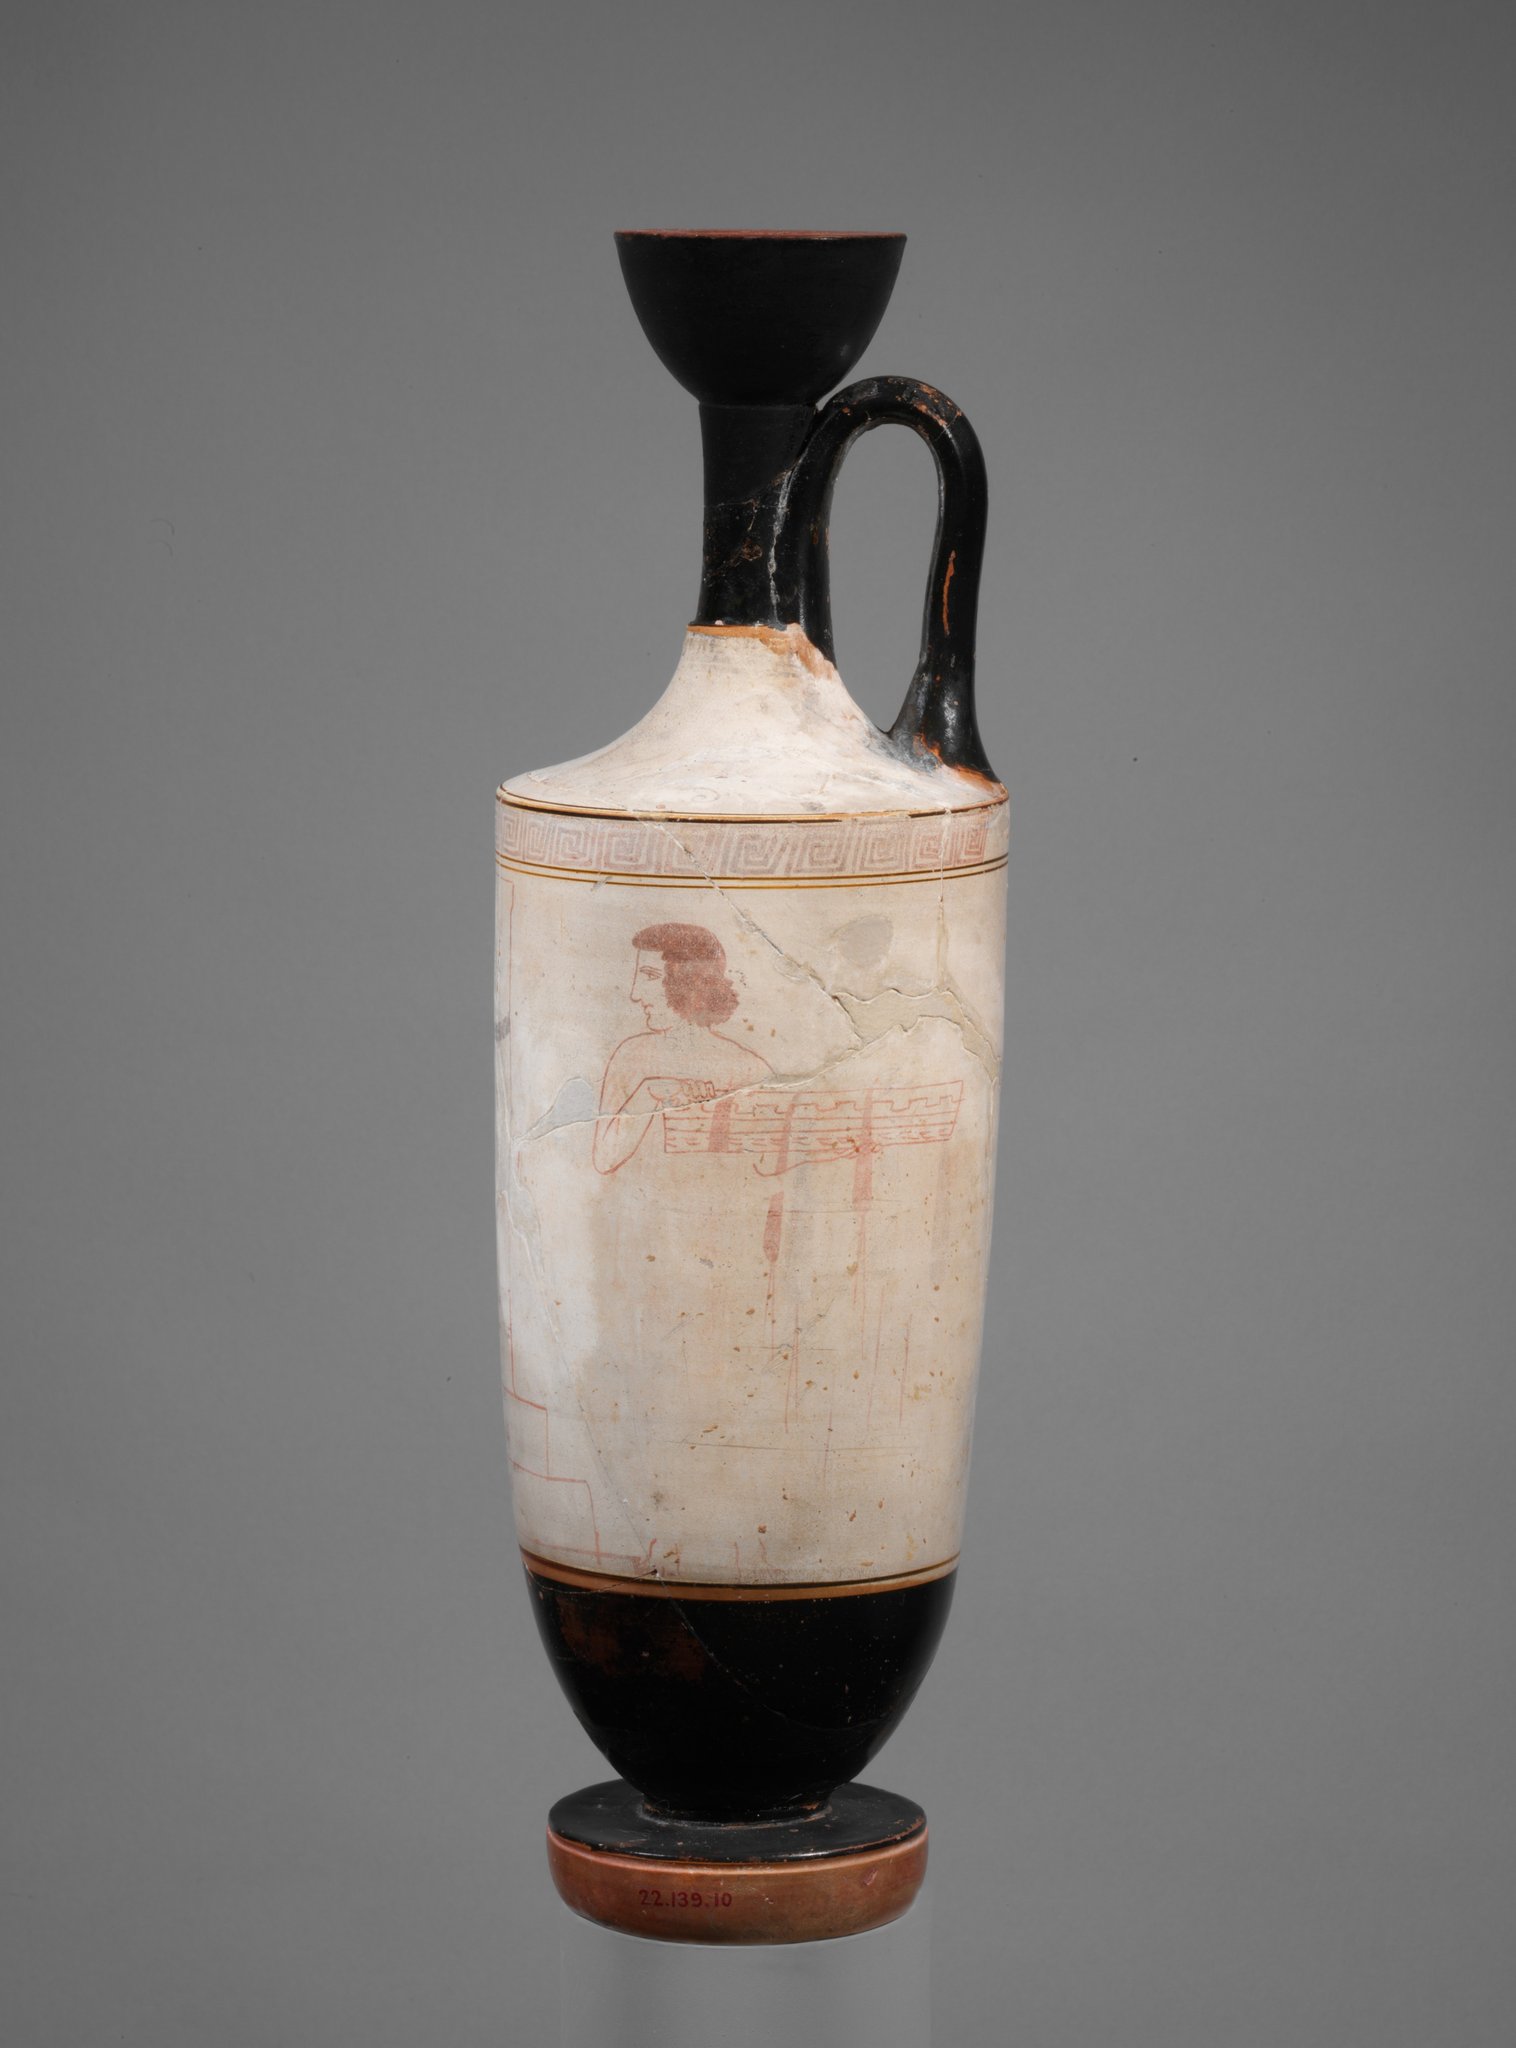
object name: lekythos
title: Terracotta lekythos (oil flask)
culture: greek, attic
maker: painter of athens 1934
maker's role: artist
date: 440-430 BCE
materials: terracotta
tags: women